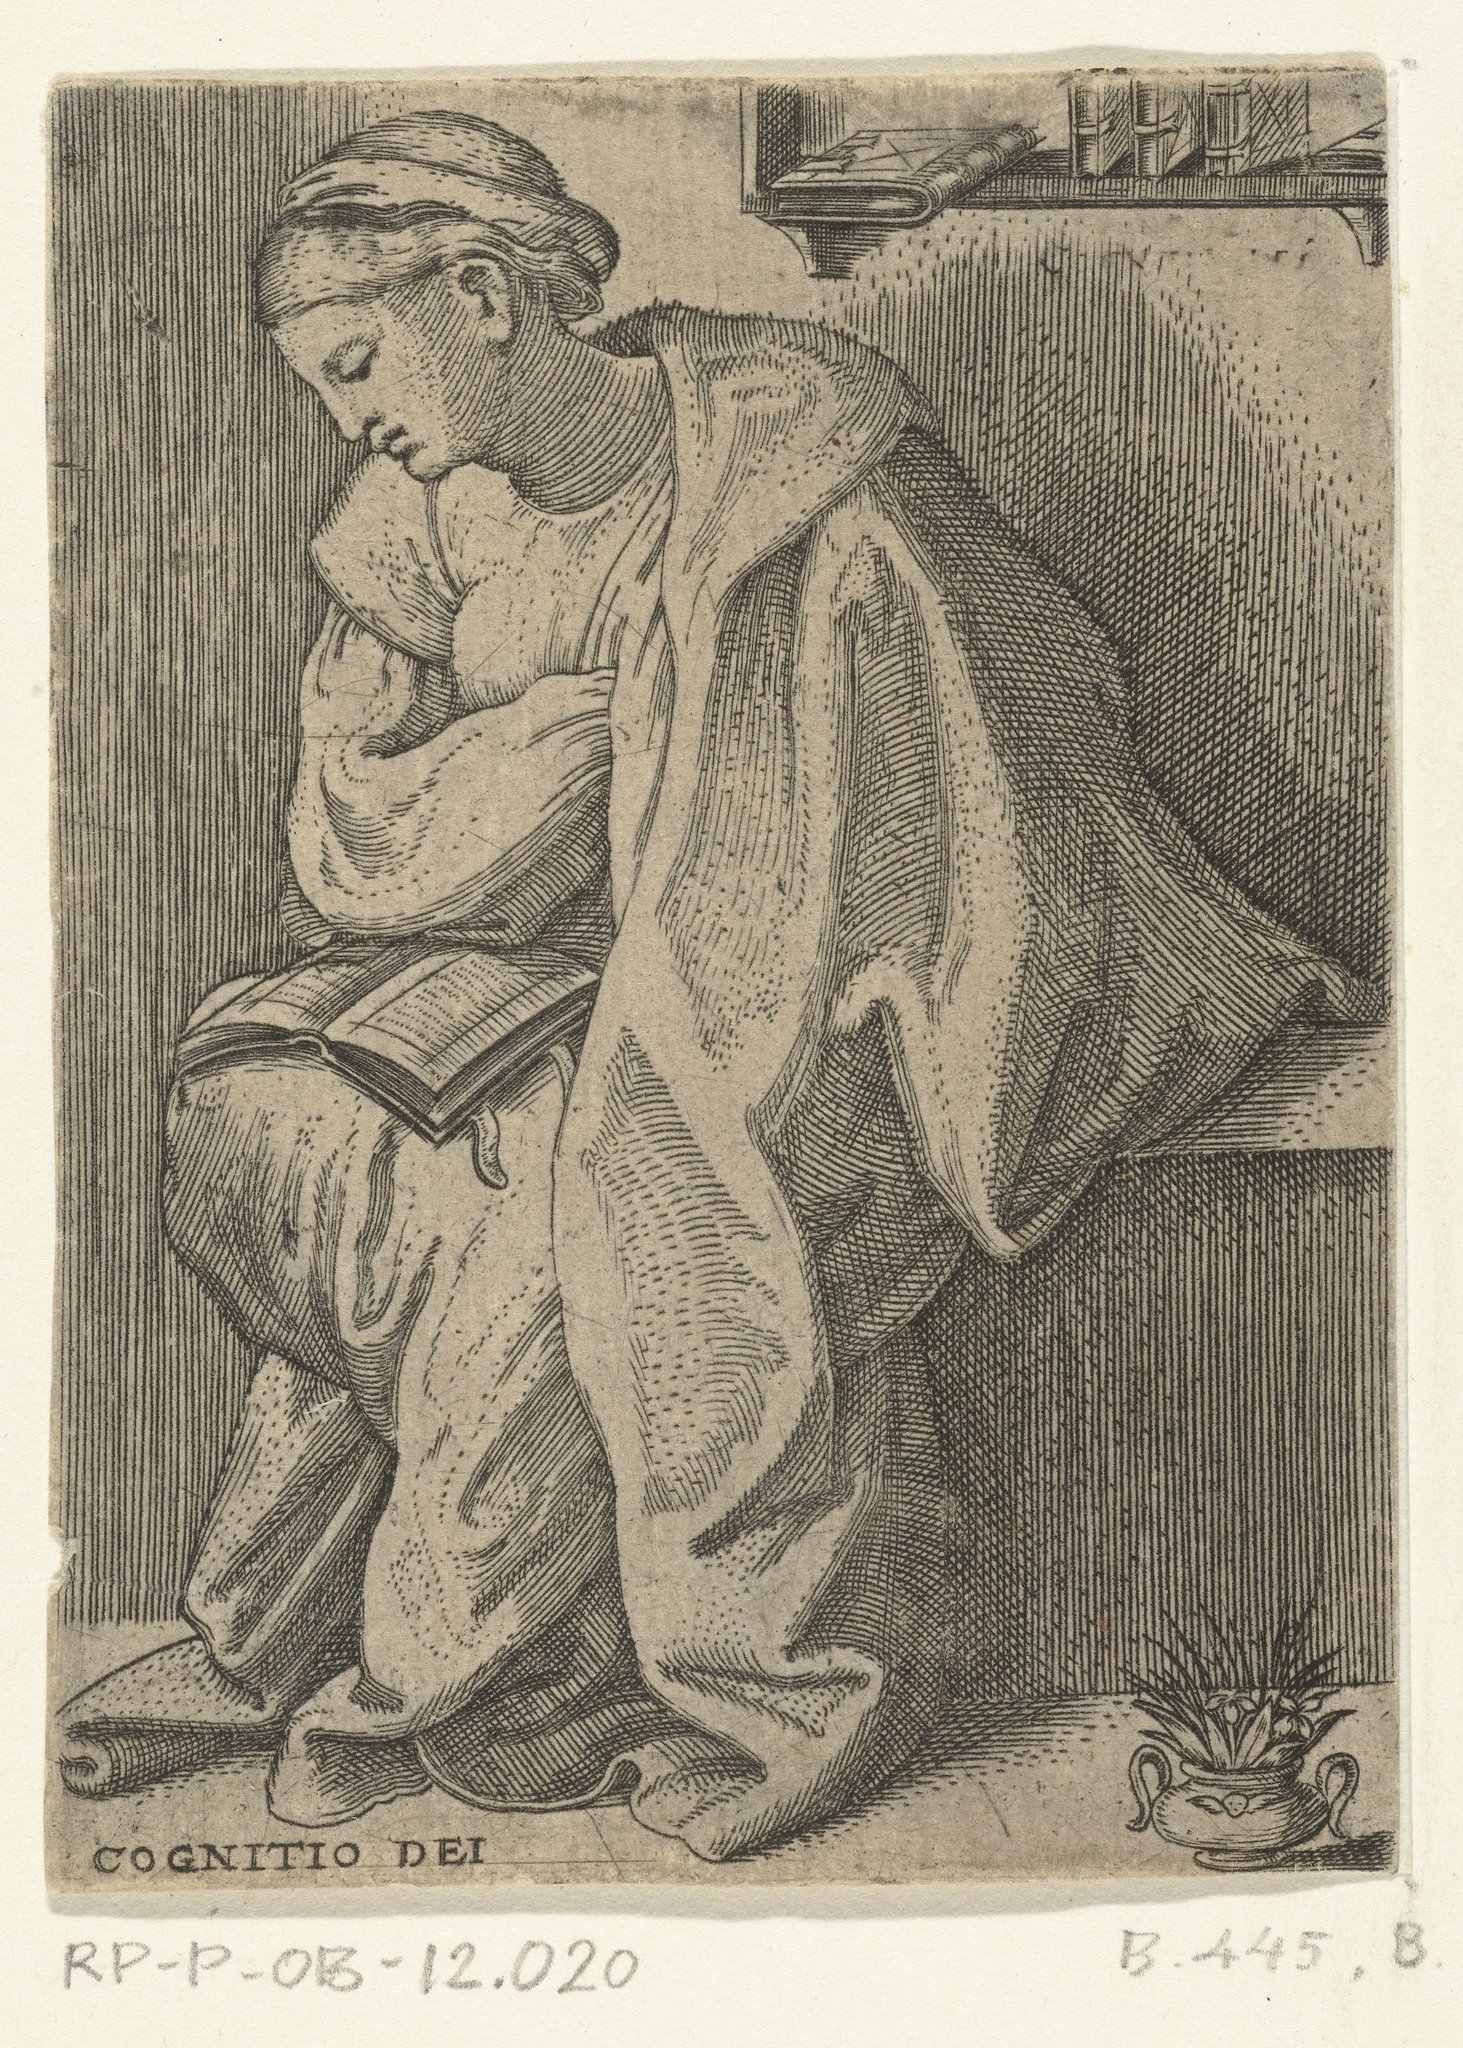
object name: print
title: Zittende vrouw in overpeinzing met boek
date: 1510-1575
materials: paper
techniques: engraving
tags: the (nude) human figure; 'corpo humano' (ripa) (+ thinking, meditating)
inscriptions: collector's mark: Lugt 12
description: Kopie in spiegelbeeld naar prent van Marcantonio Raimondi. Raimondi baseerde zich mogelijk op een ontwerp van Raphael.